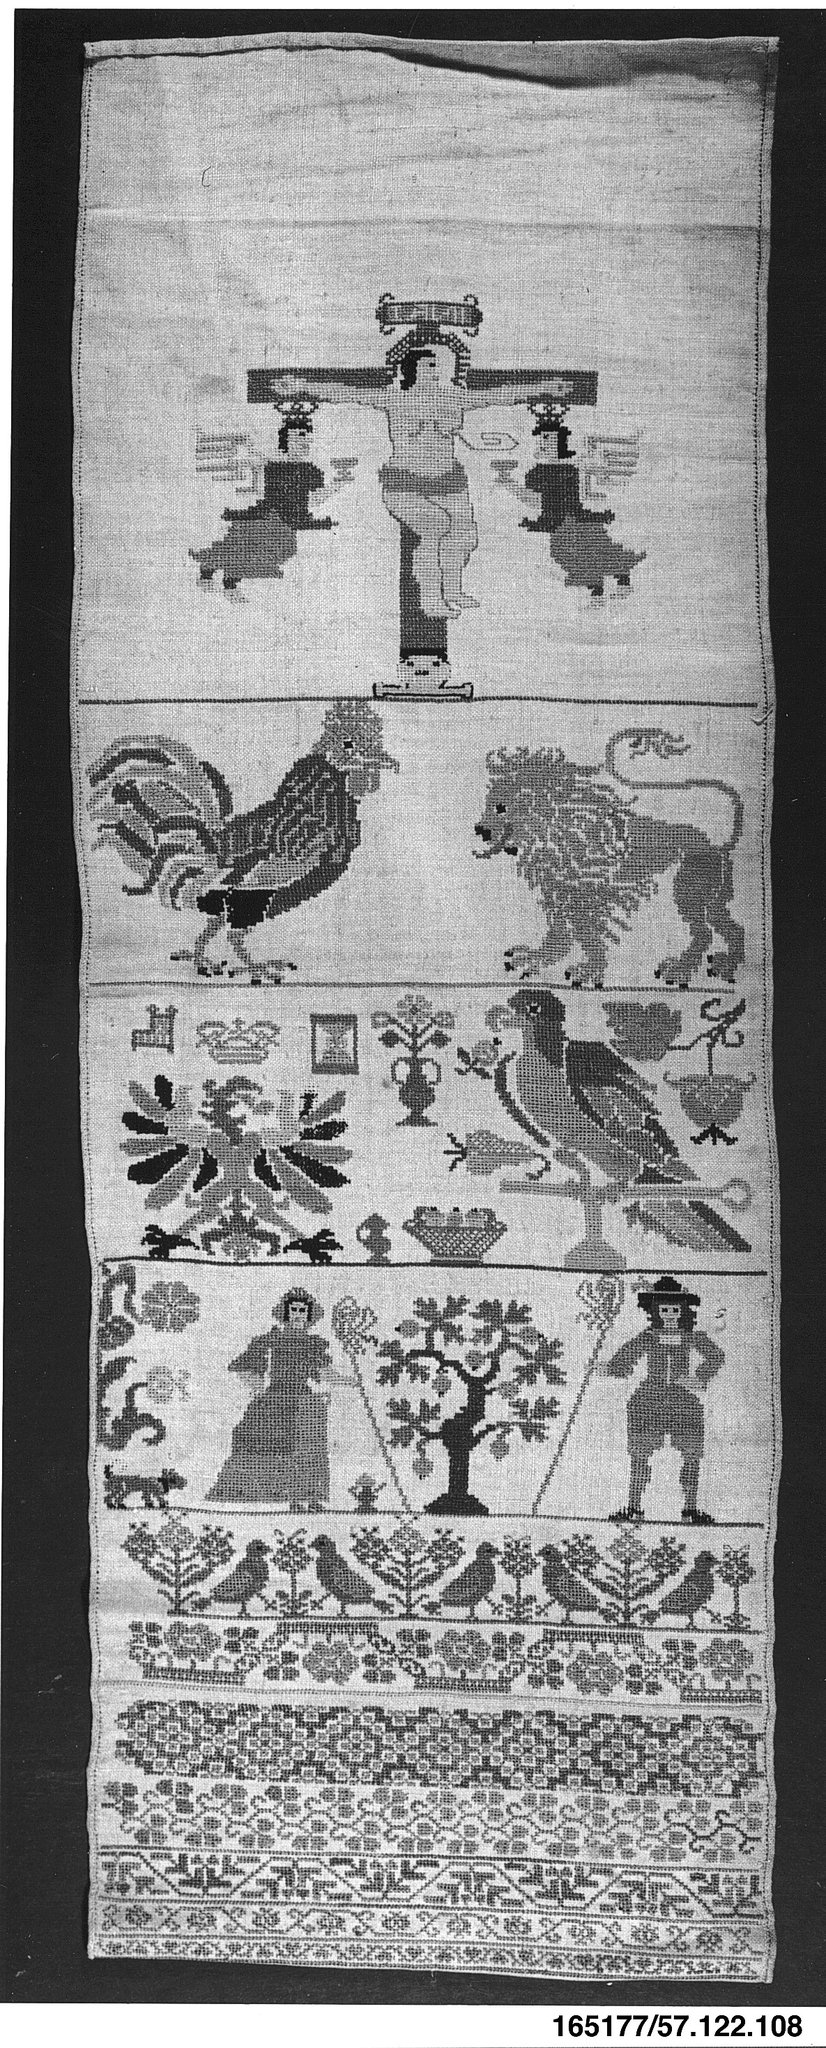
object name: sampler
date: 1701-1800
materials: linen, silk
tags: birds,lions,crucifixion